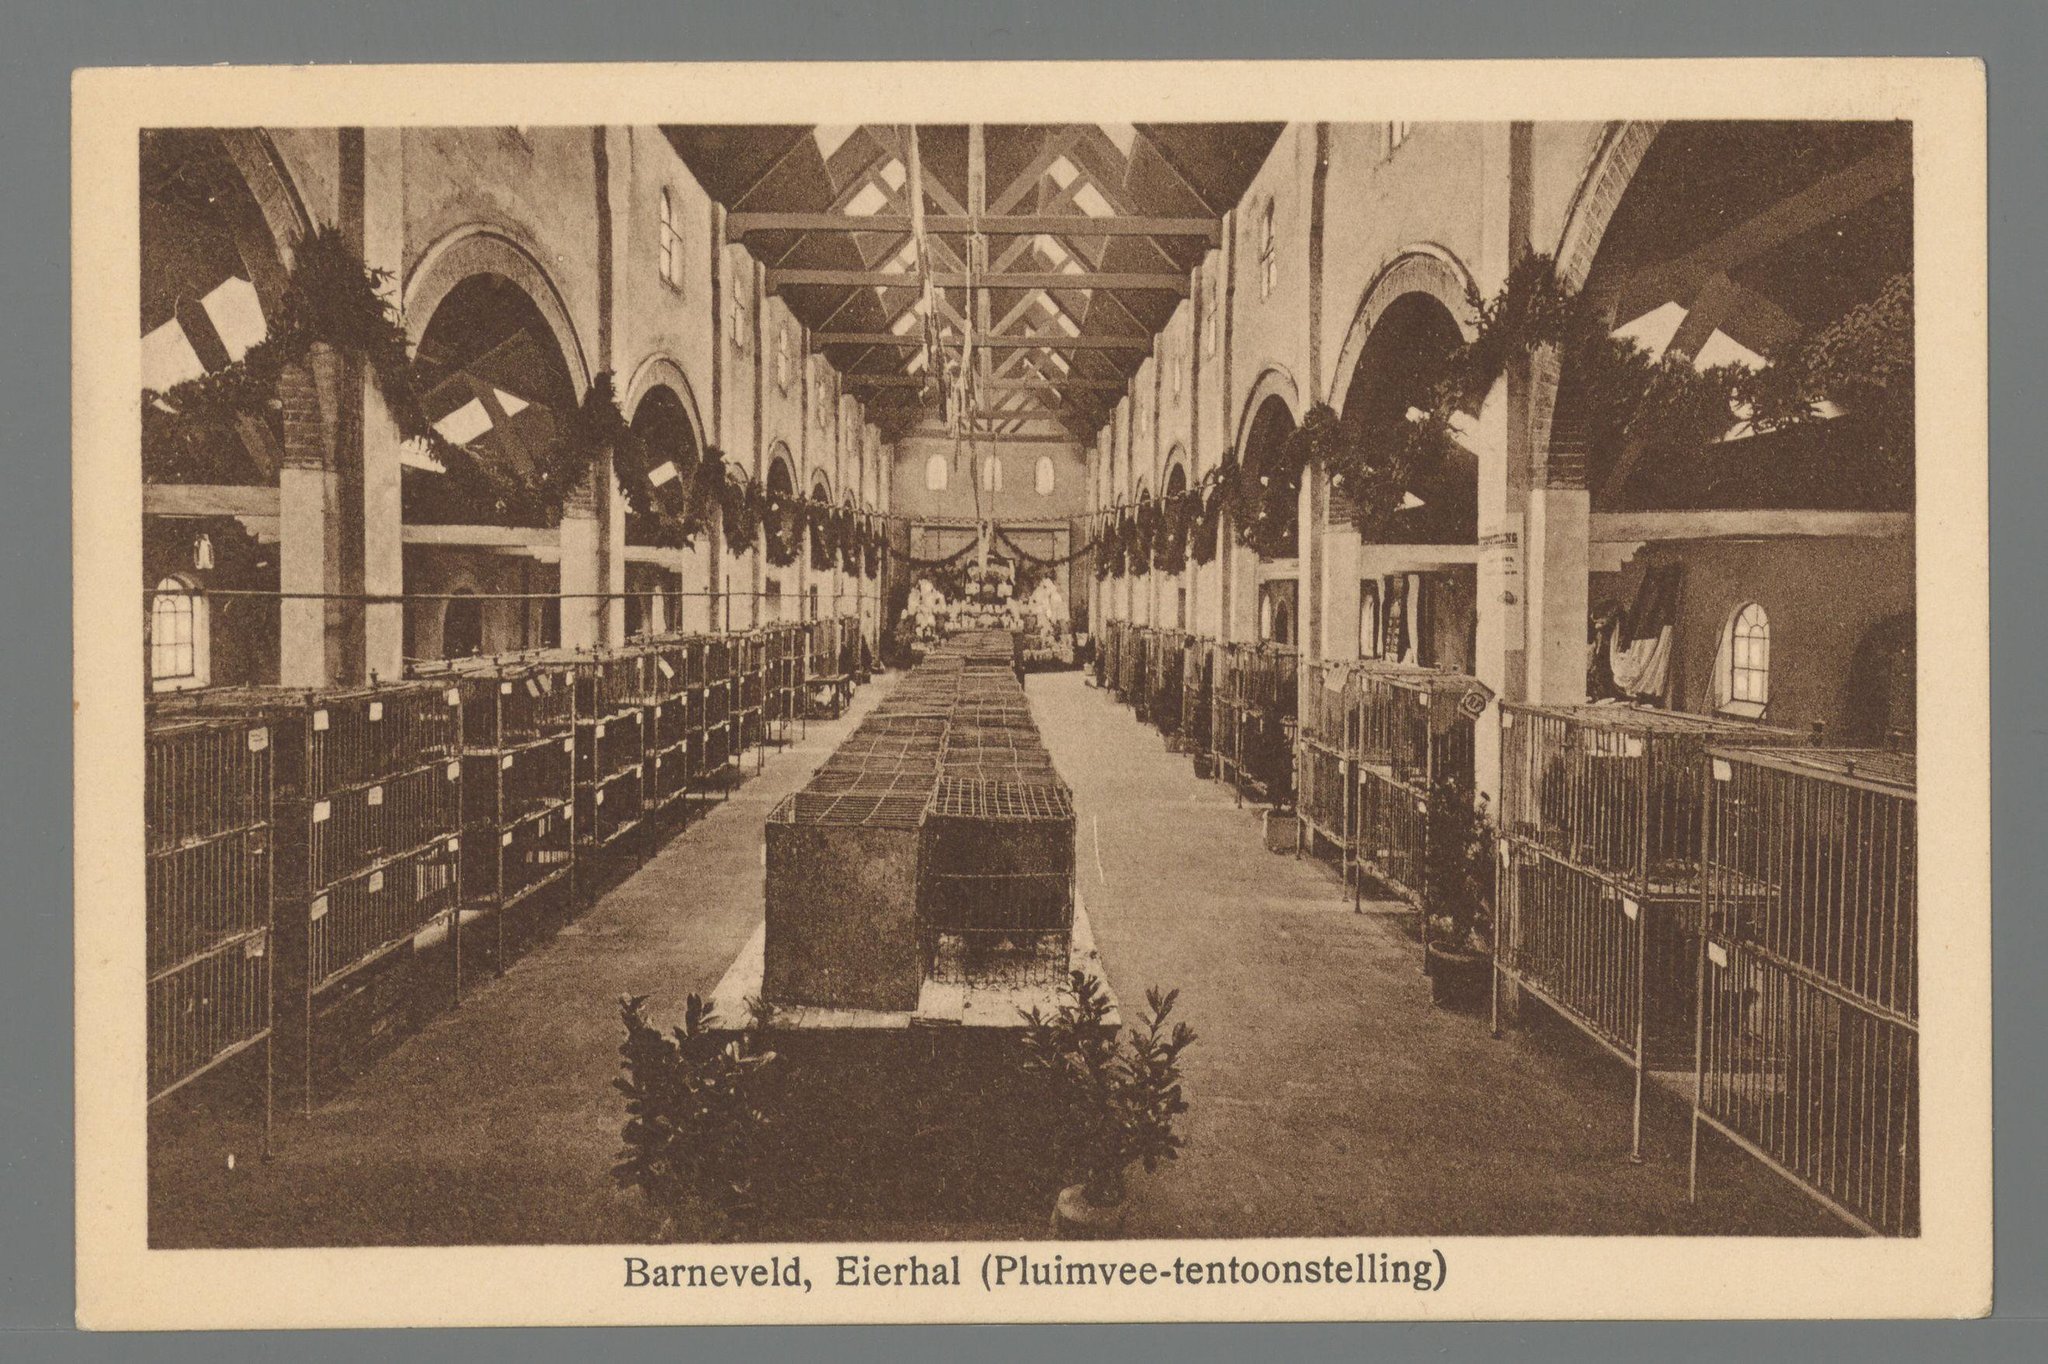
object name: photomechanical print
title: Barneveld, eierhal (pluimvee-tentoonstelling)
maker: Anonymous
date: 1913-1930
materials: cardboard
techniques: photograph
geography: barneveld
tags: fowl (cock, hen, chicken, etc.), temporary exhibition, 'salon'